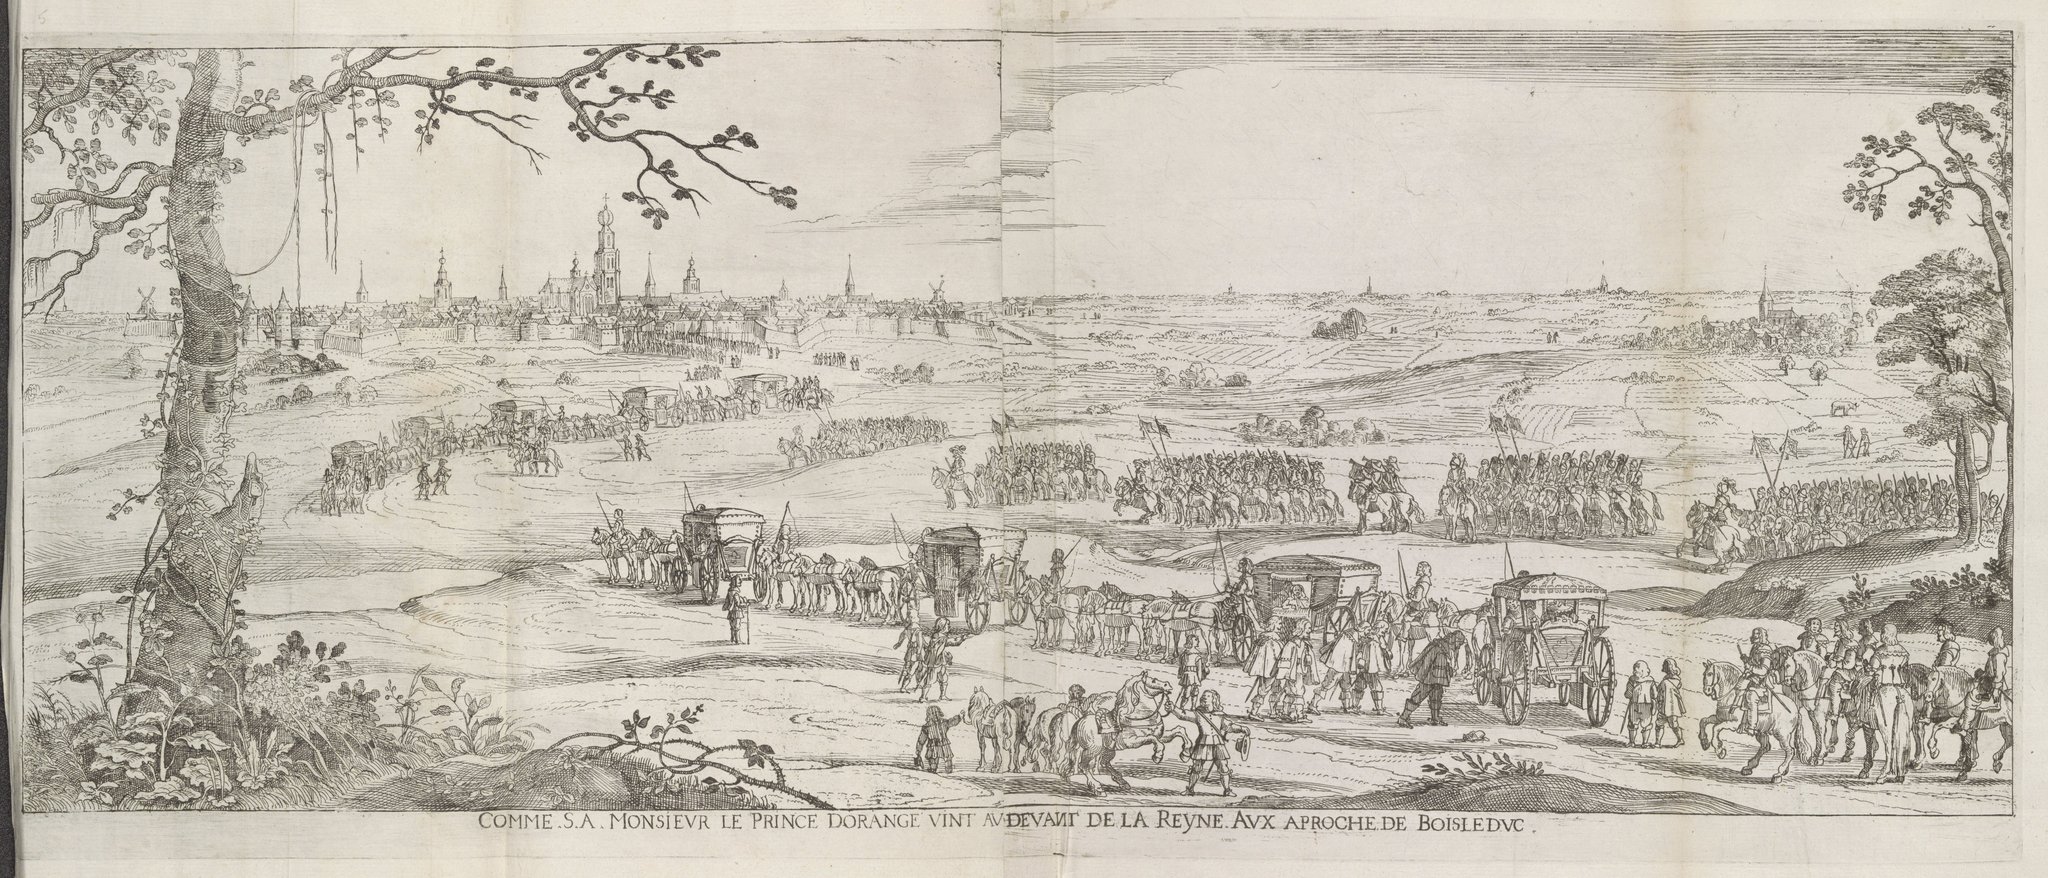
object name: print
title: Comme s.a. monsieur le prince dOrange vint au devant de la reyne, aux aproche de Bois le duc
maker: Anonymous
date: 1639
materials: paper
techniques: etching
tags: the hague, frederick henry (prince of orange), cologne, print maker, maria de' medici, triumphal entry and public reception, pageant, 'entrée solennelle', 'joyeuse entrée', den bosch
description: Stadhouder Frederik Hendrik komt de Franse koningin Maria de Médici tegemoet, buiten 's-Hertogenbosch, augustus 1638. Landschap met de twee gezelschappen met wagens en soldaten, in de verte het profiel van Den Bosch. De prent maakt deel uit van een boek over het bezoek van Maria de' Medici aan de Nederlanden.